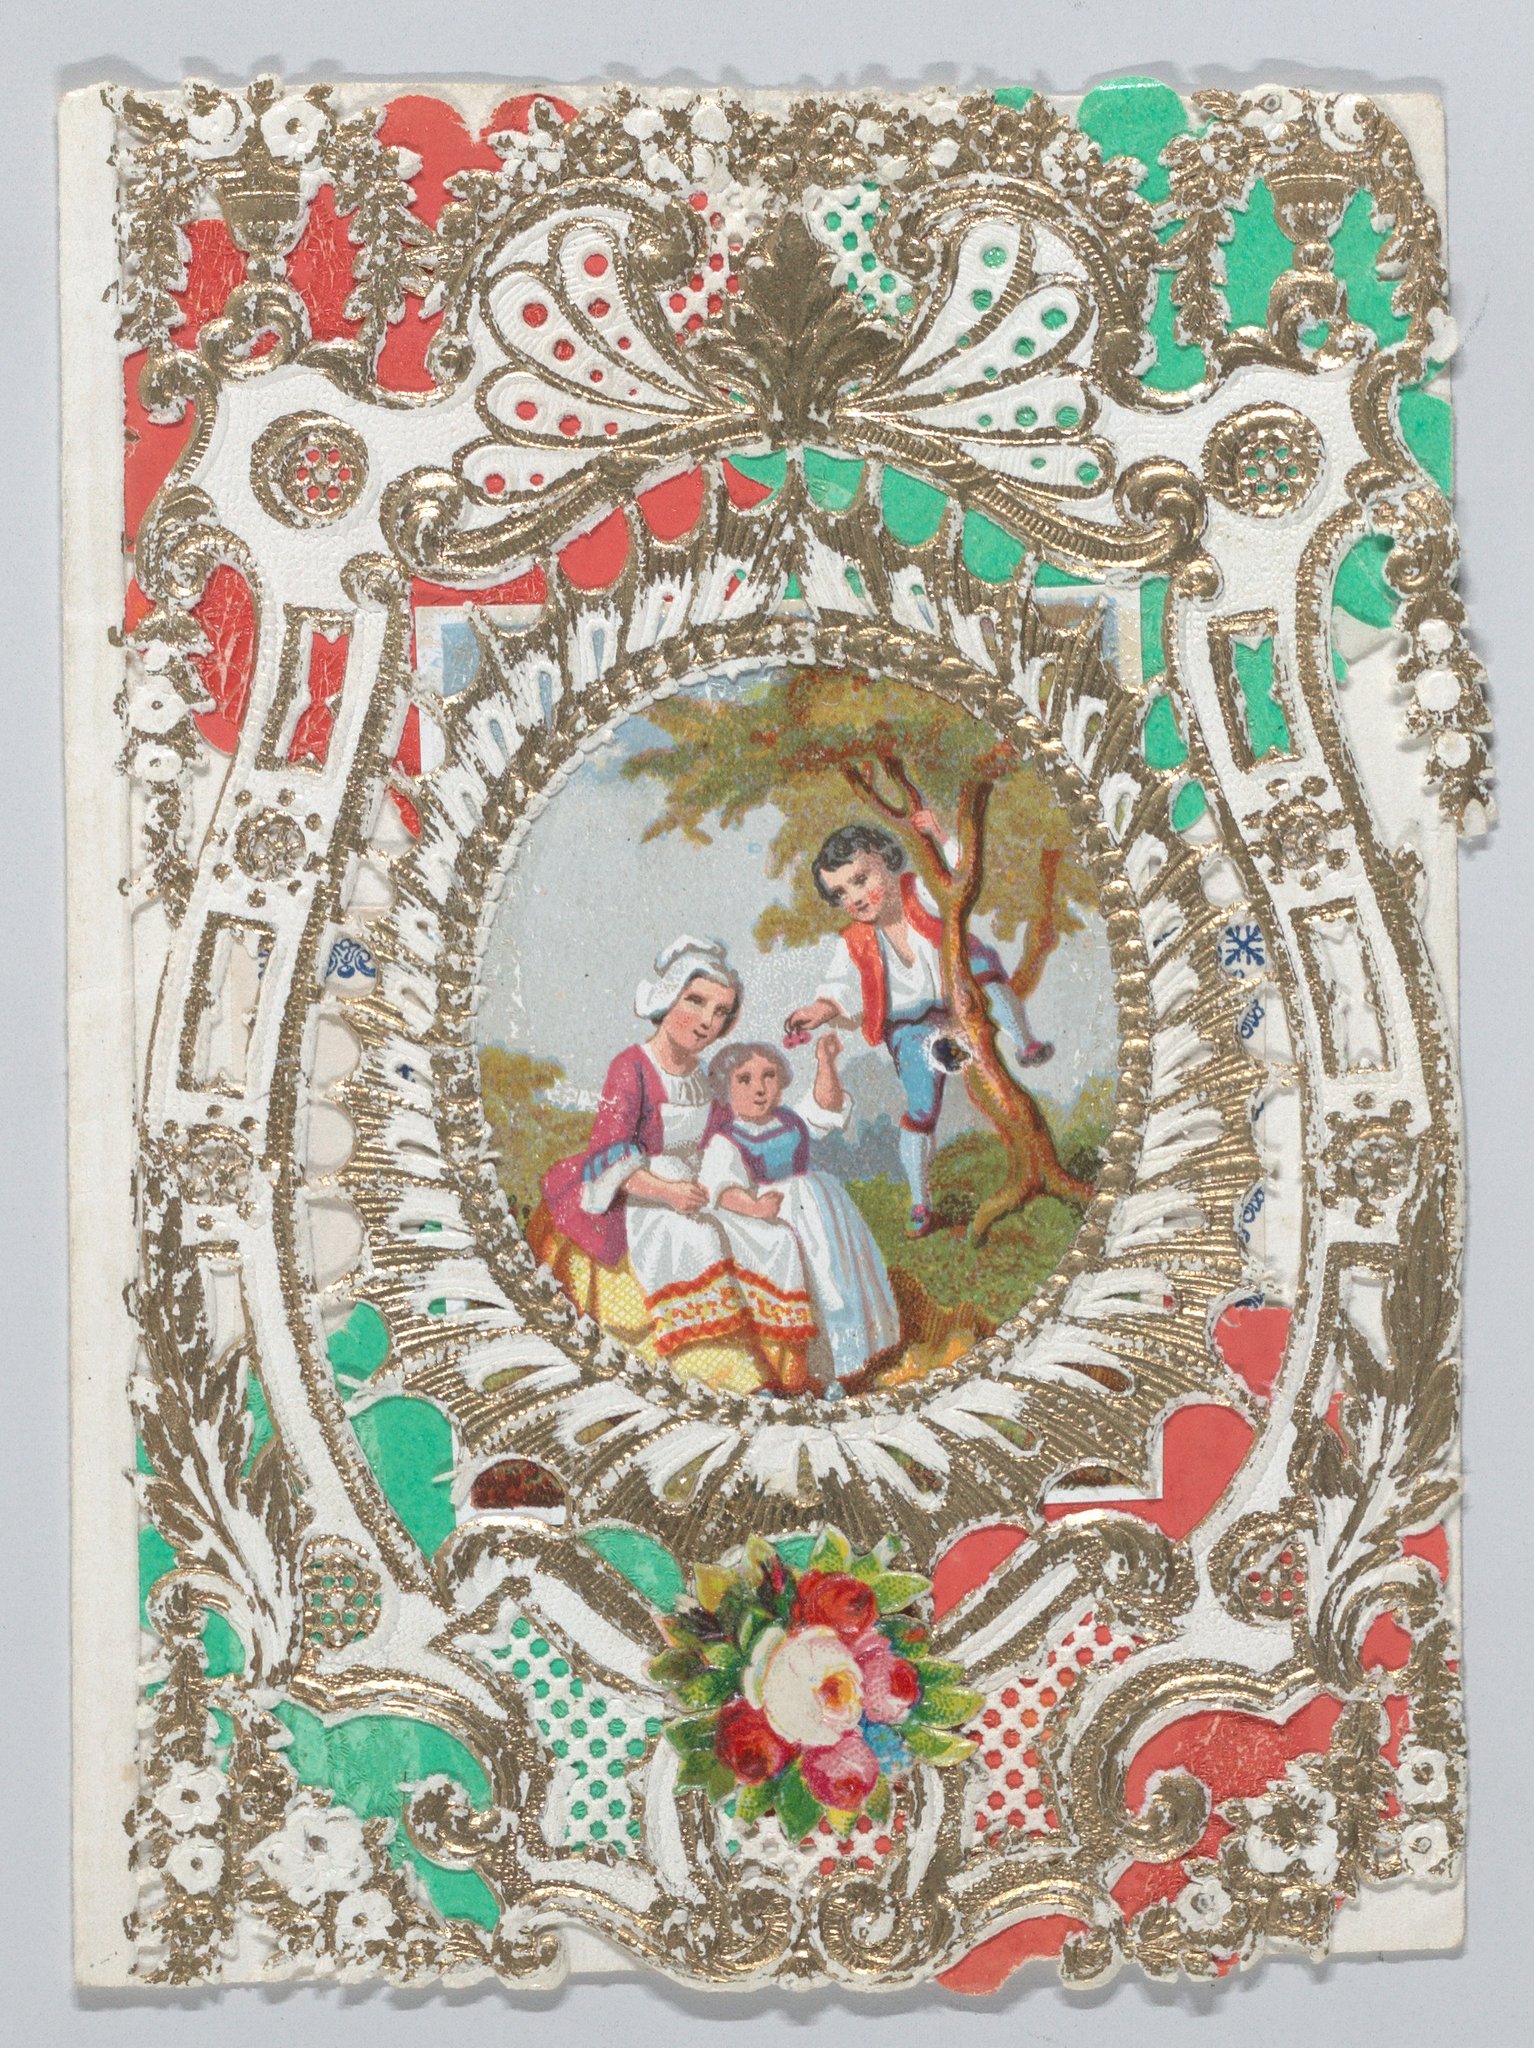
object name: valentine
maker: Anonymous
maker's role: artist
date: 1850-1860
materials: paper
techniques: chromolithography, embossing, gilding, open work